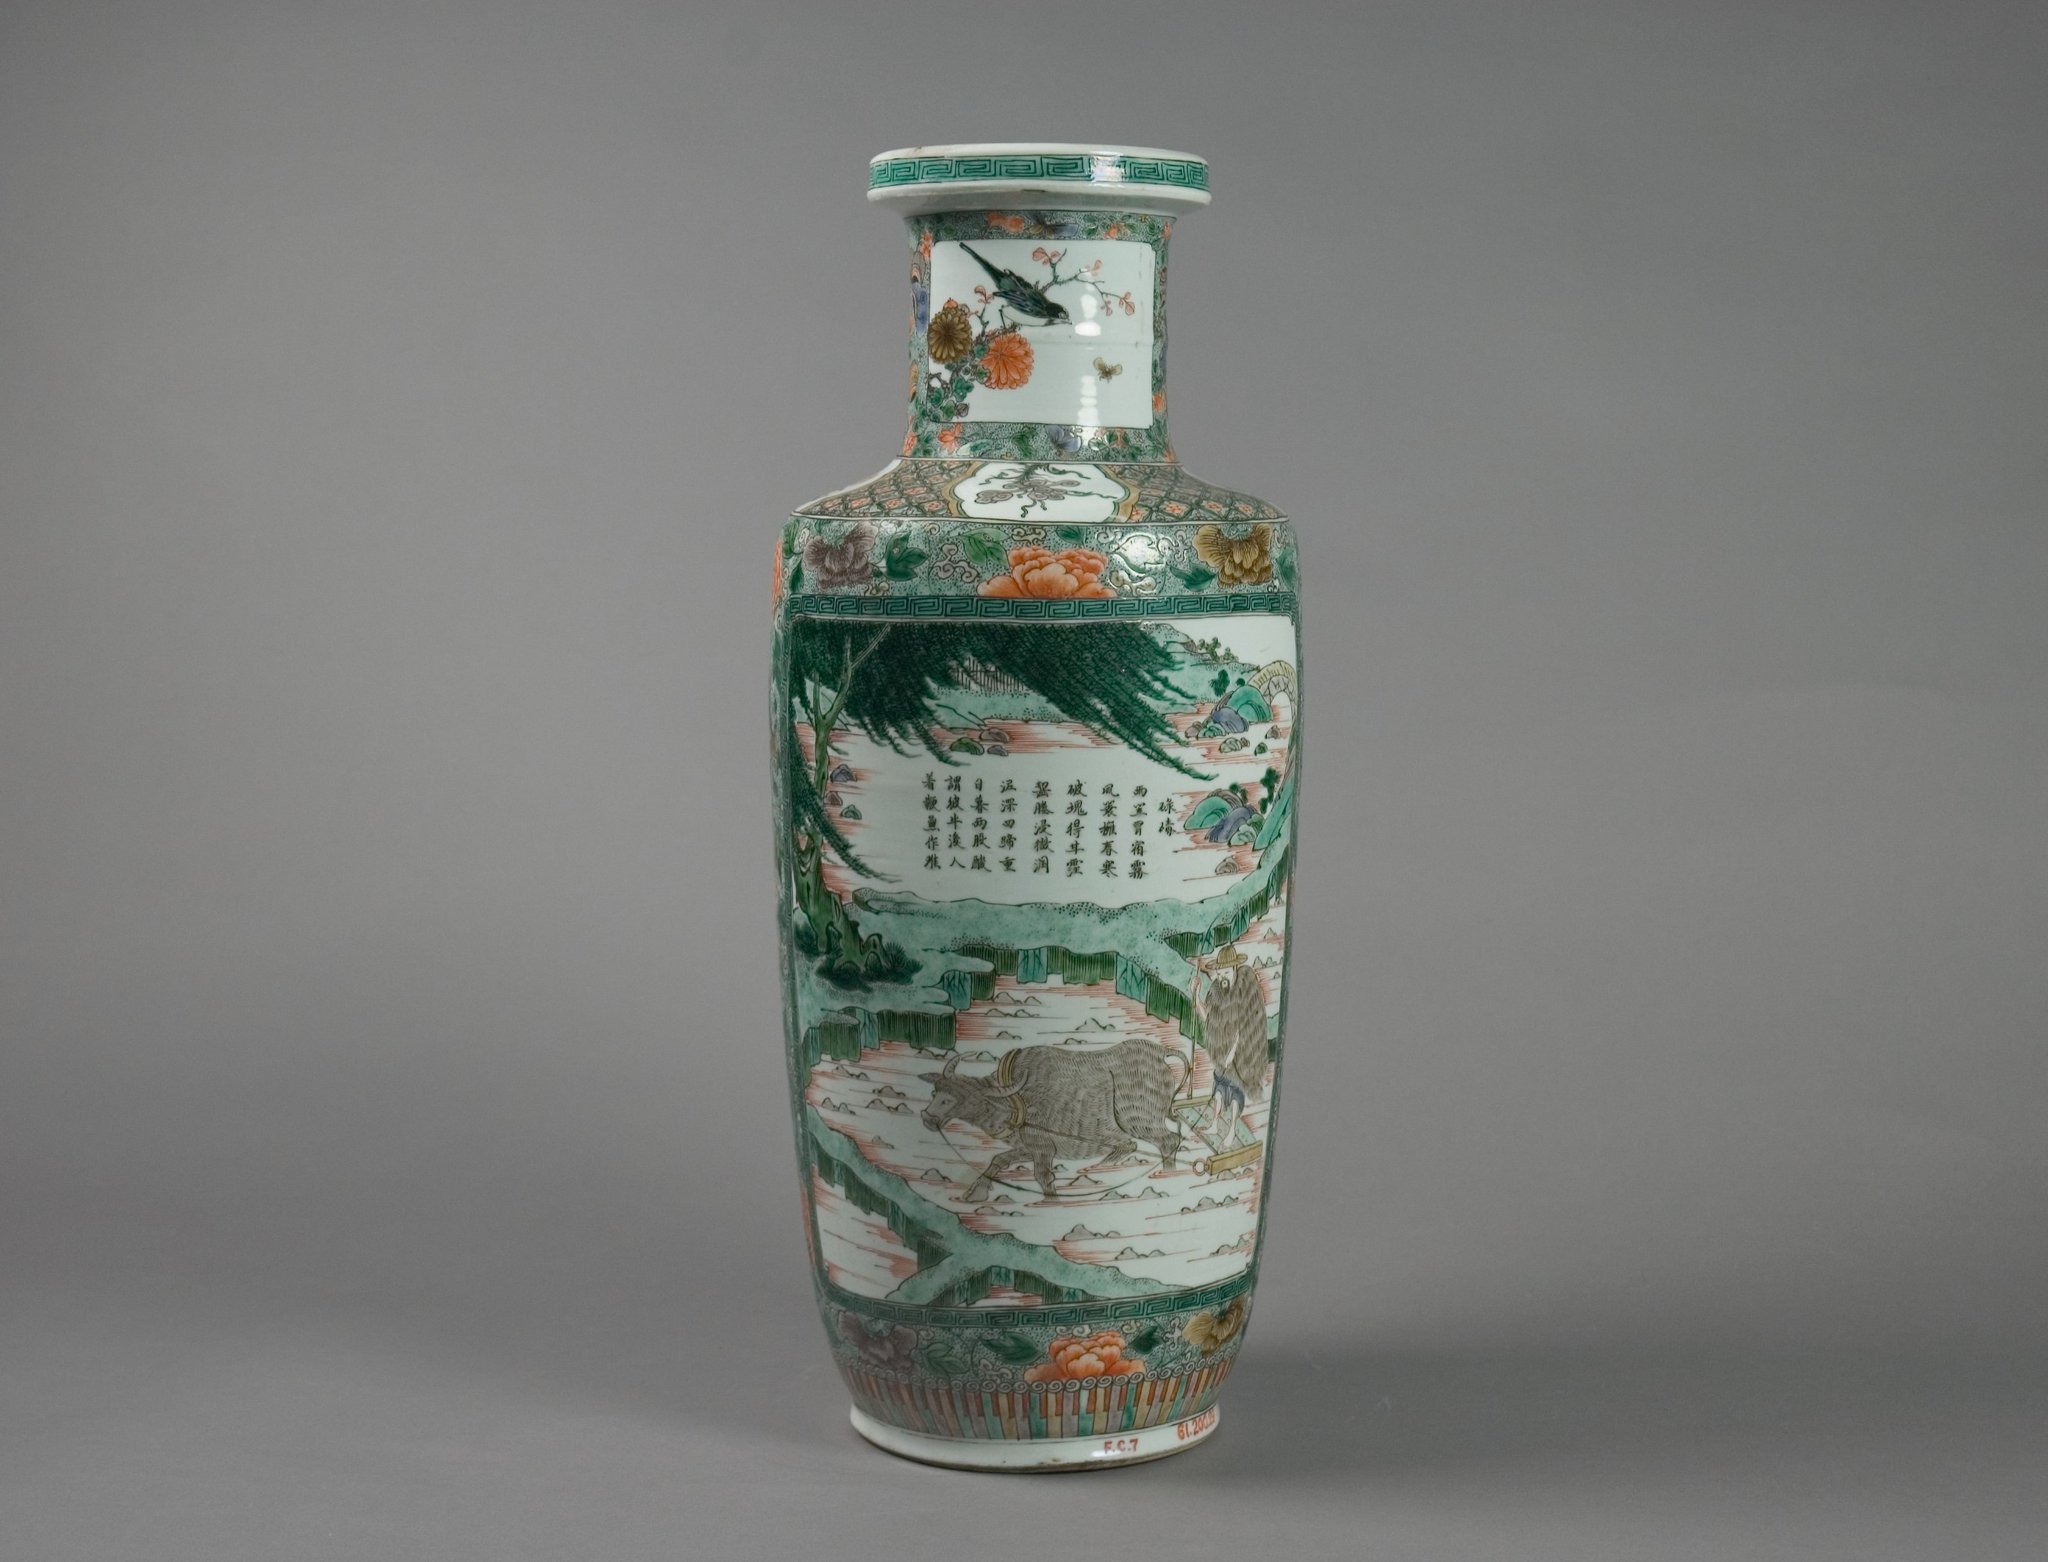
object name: vase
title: Vase with scenes and poems from Farming and Weaving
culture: chinese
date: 1662-1722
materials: enamel, porcelain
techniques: overglaze, painting, polychrome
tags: animals,birds,flowers